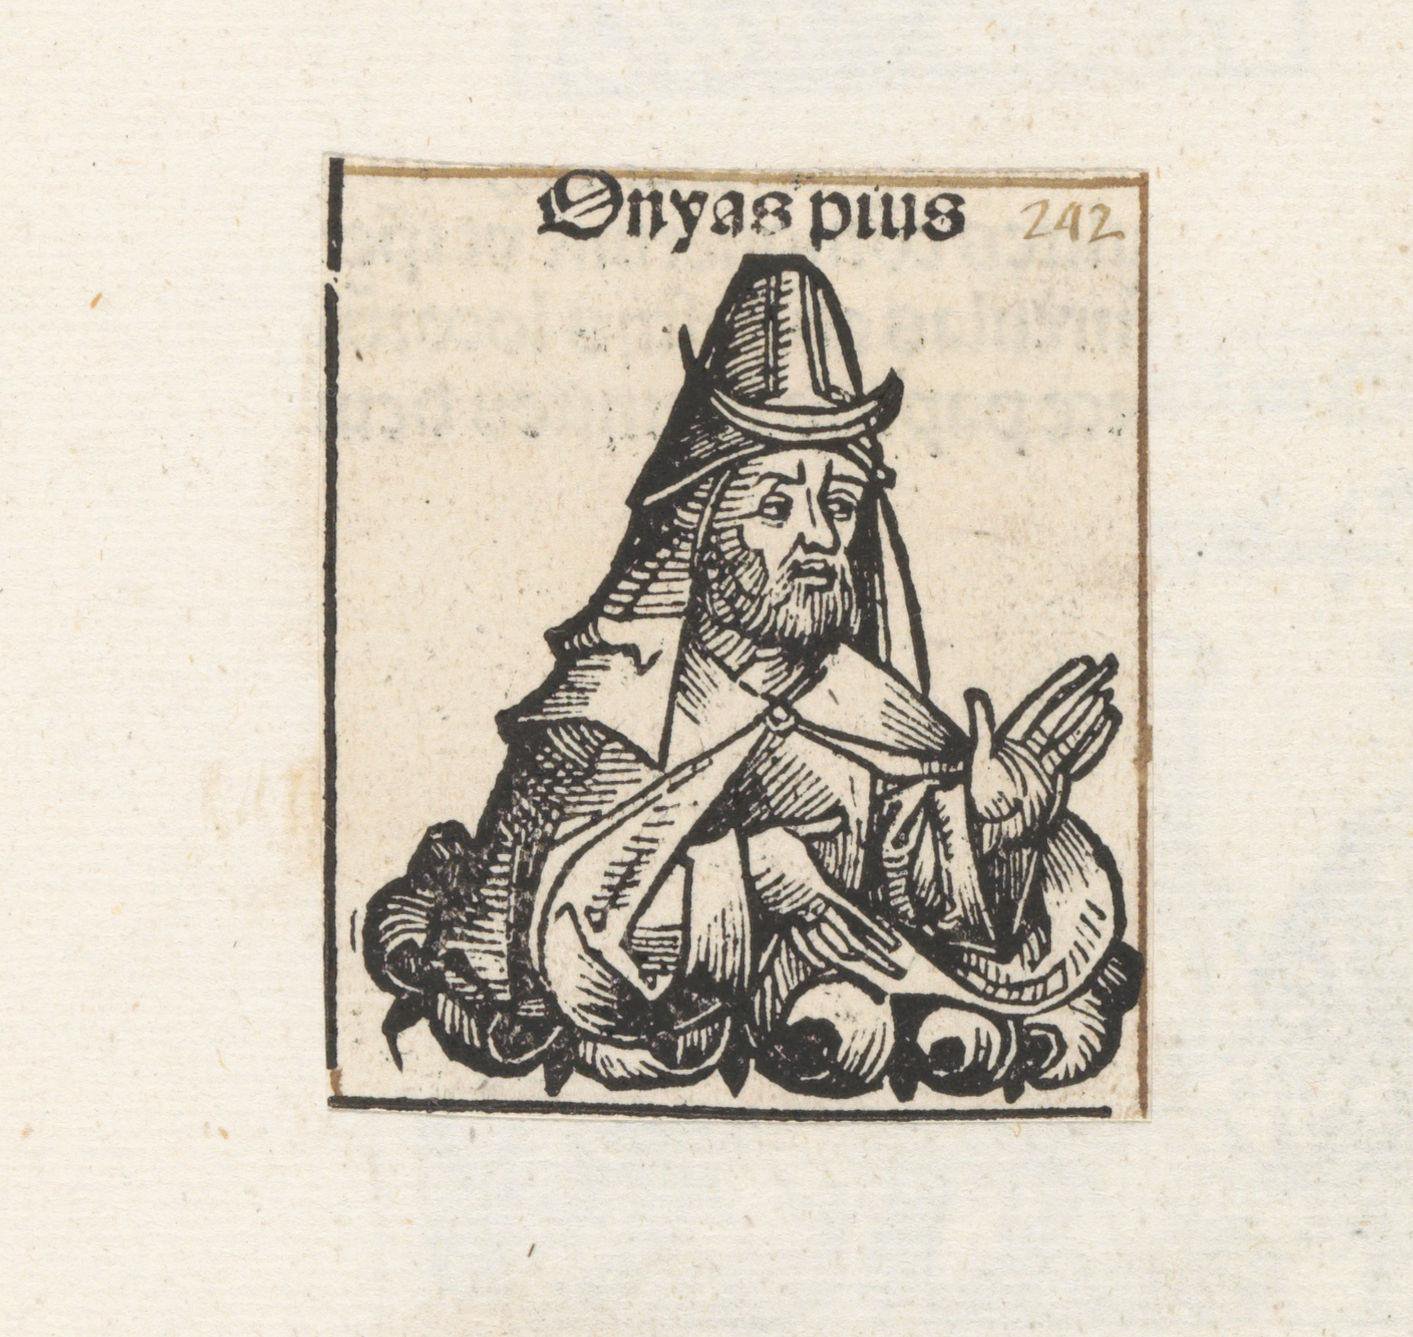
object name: album leaf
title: Onias pius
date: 1493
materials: paper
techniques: letterpress printing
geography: nuremberg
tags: high priest ~ hierarchy of priests, persons from the old testament (not in biblical context, nor occurring in legendary/historical extensions included in division 71)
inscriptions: inscription: ‘242’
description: Een bloemkelk met een man in priesterkledij, naar rechts gekeerd. De tekst identificeert hem als Onias, hogepriester. Mogelijk gaat het om Onias III, zoon van Simon II. De voorstelling is onderdeel van de opeenvolging priesters in de Liber Chronicarum. De prent maakt deel uit van een album.